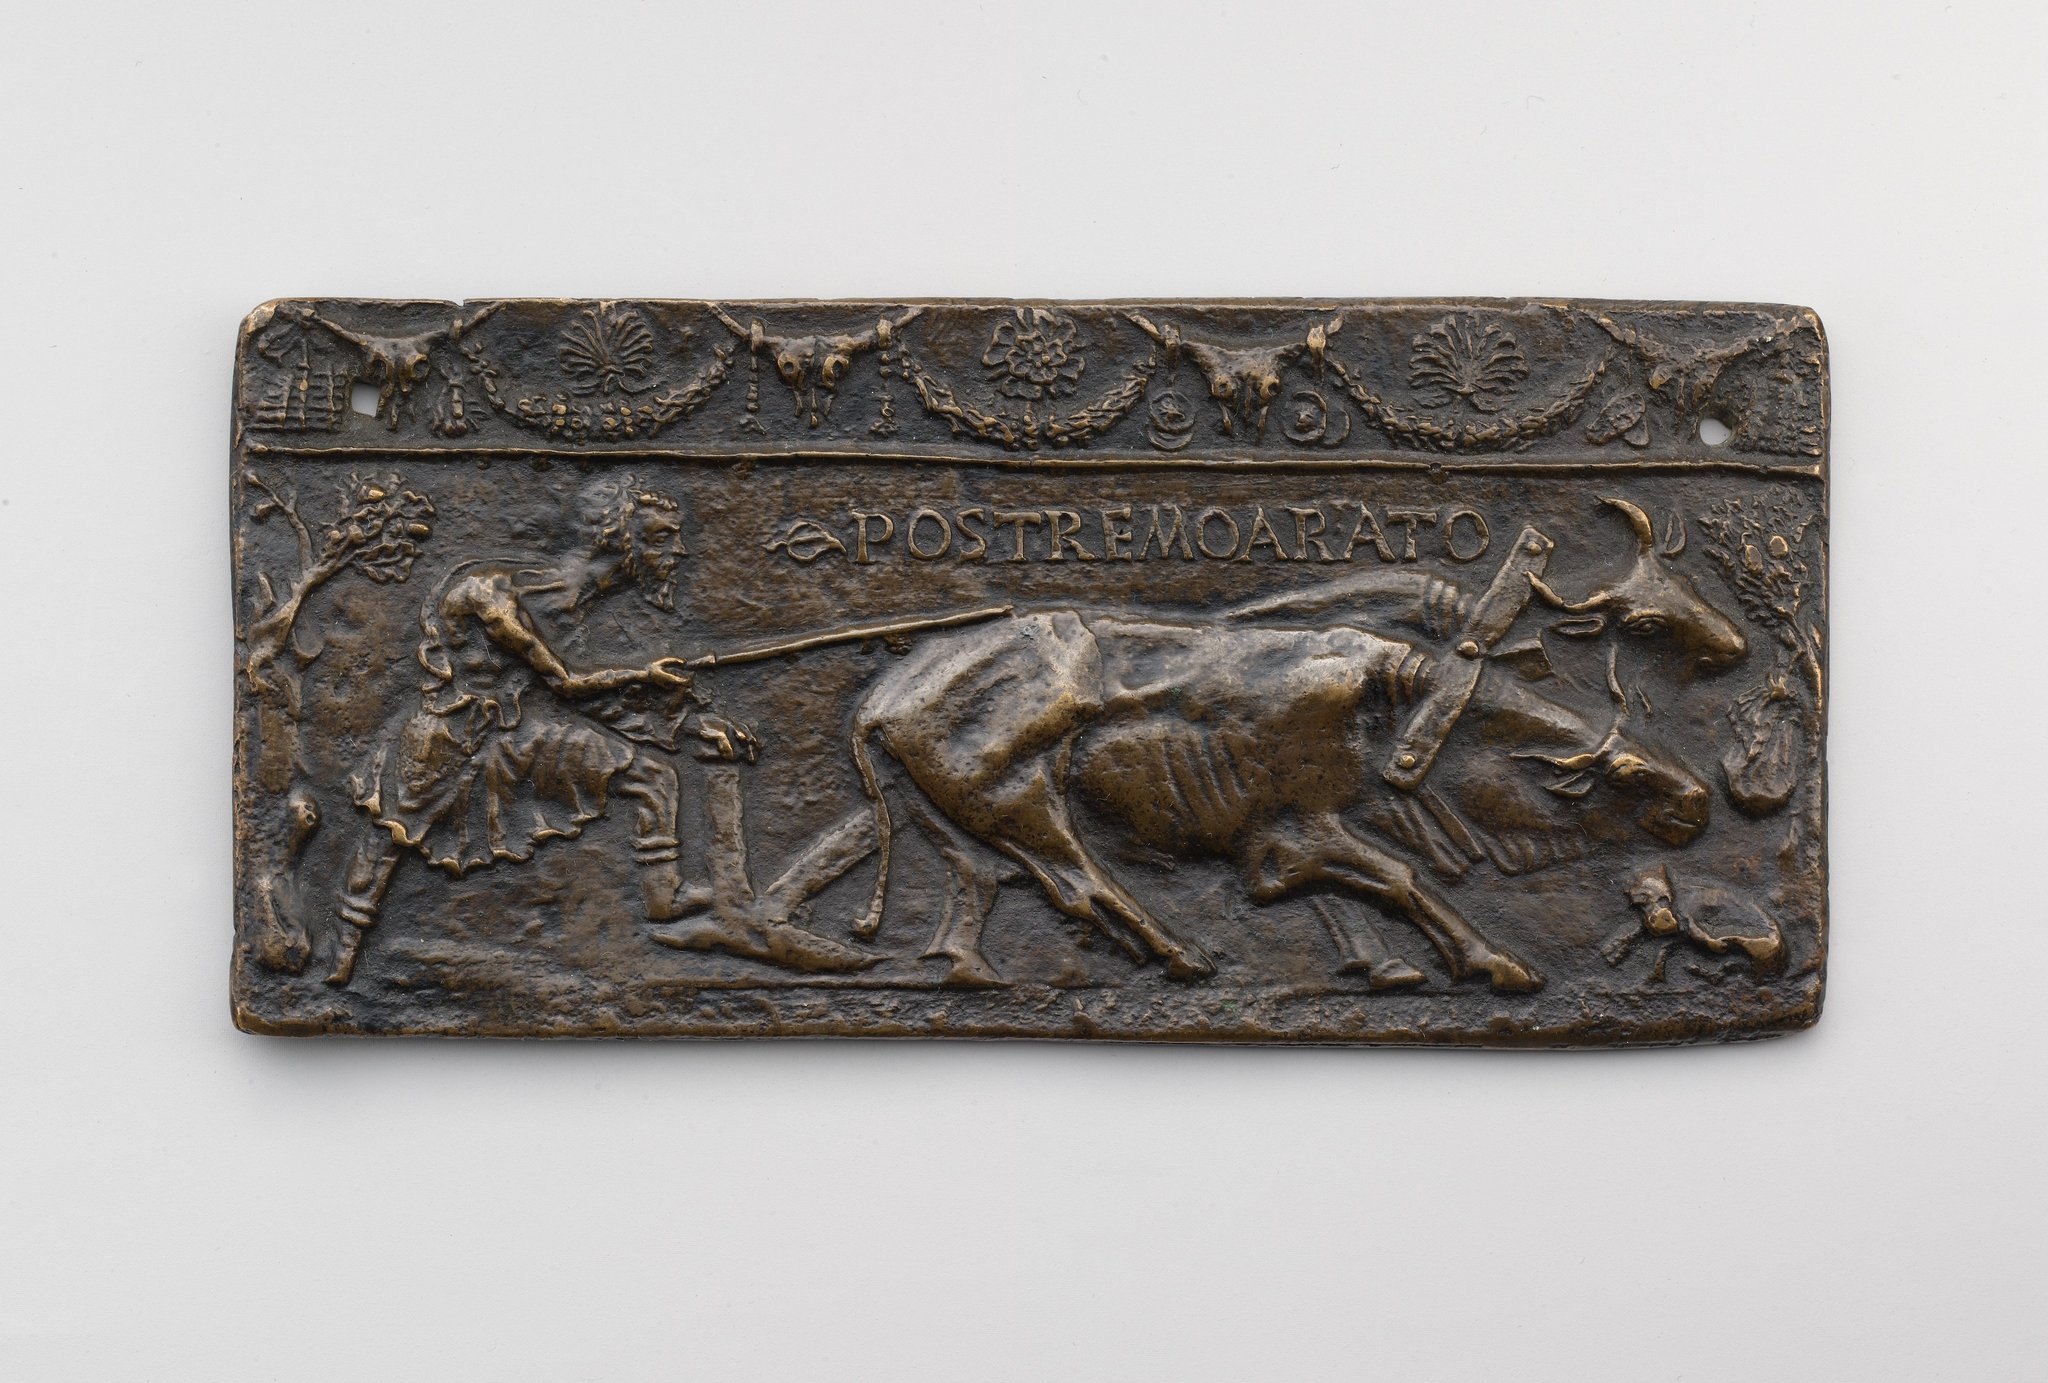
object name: plaquette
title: Cincinnatus at the Plough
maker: filarete (antonio di pietro averlino)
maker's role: artist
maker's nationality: italian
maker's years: 1400-1469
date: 1434-1466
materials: bronze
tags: men,working,ox